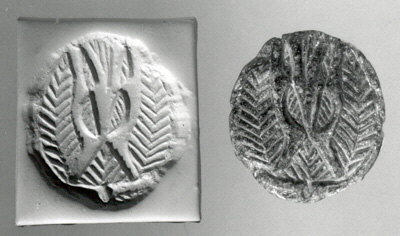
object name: stamp seal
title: Carinated lentoid seal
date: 4500-3600 BCE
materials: mineral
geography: northern syria or eastern anatolia